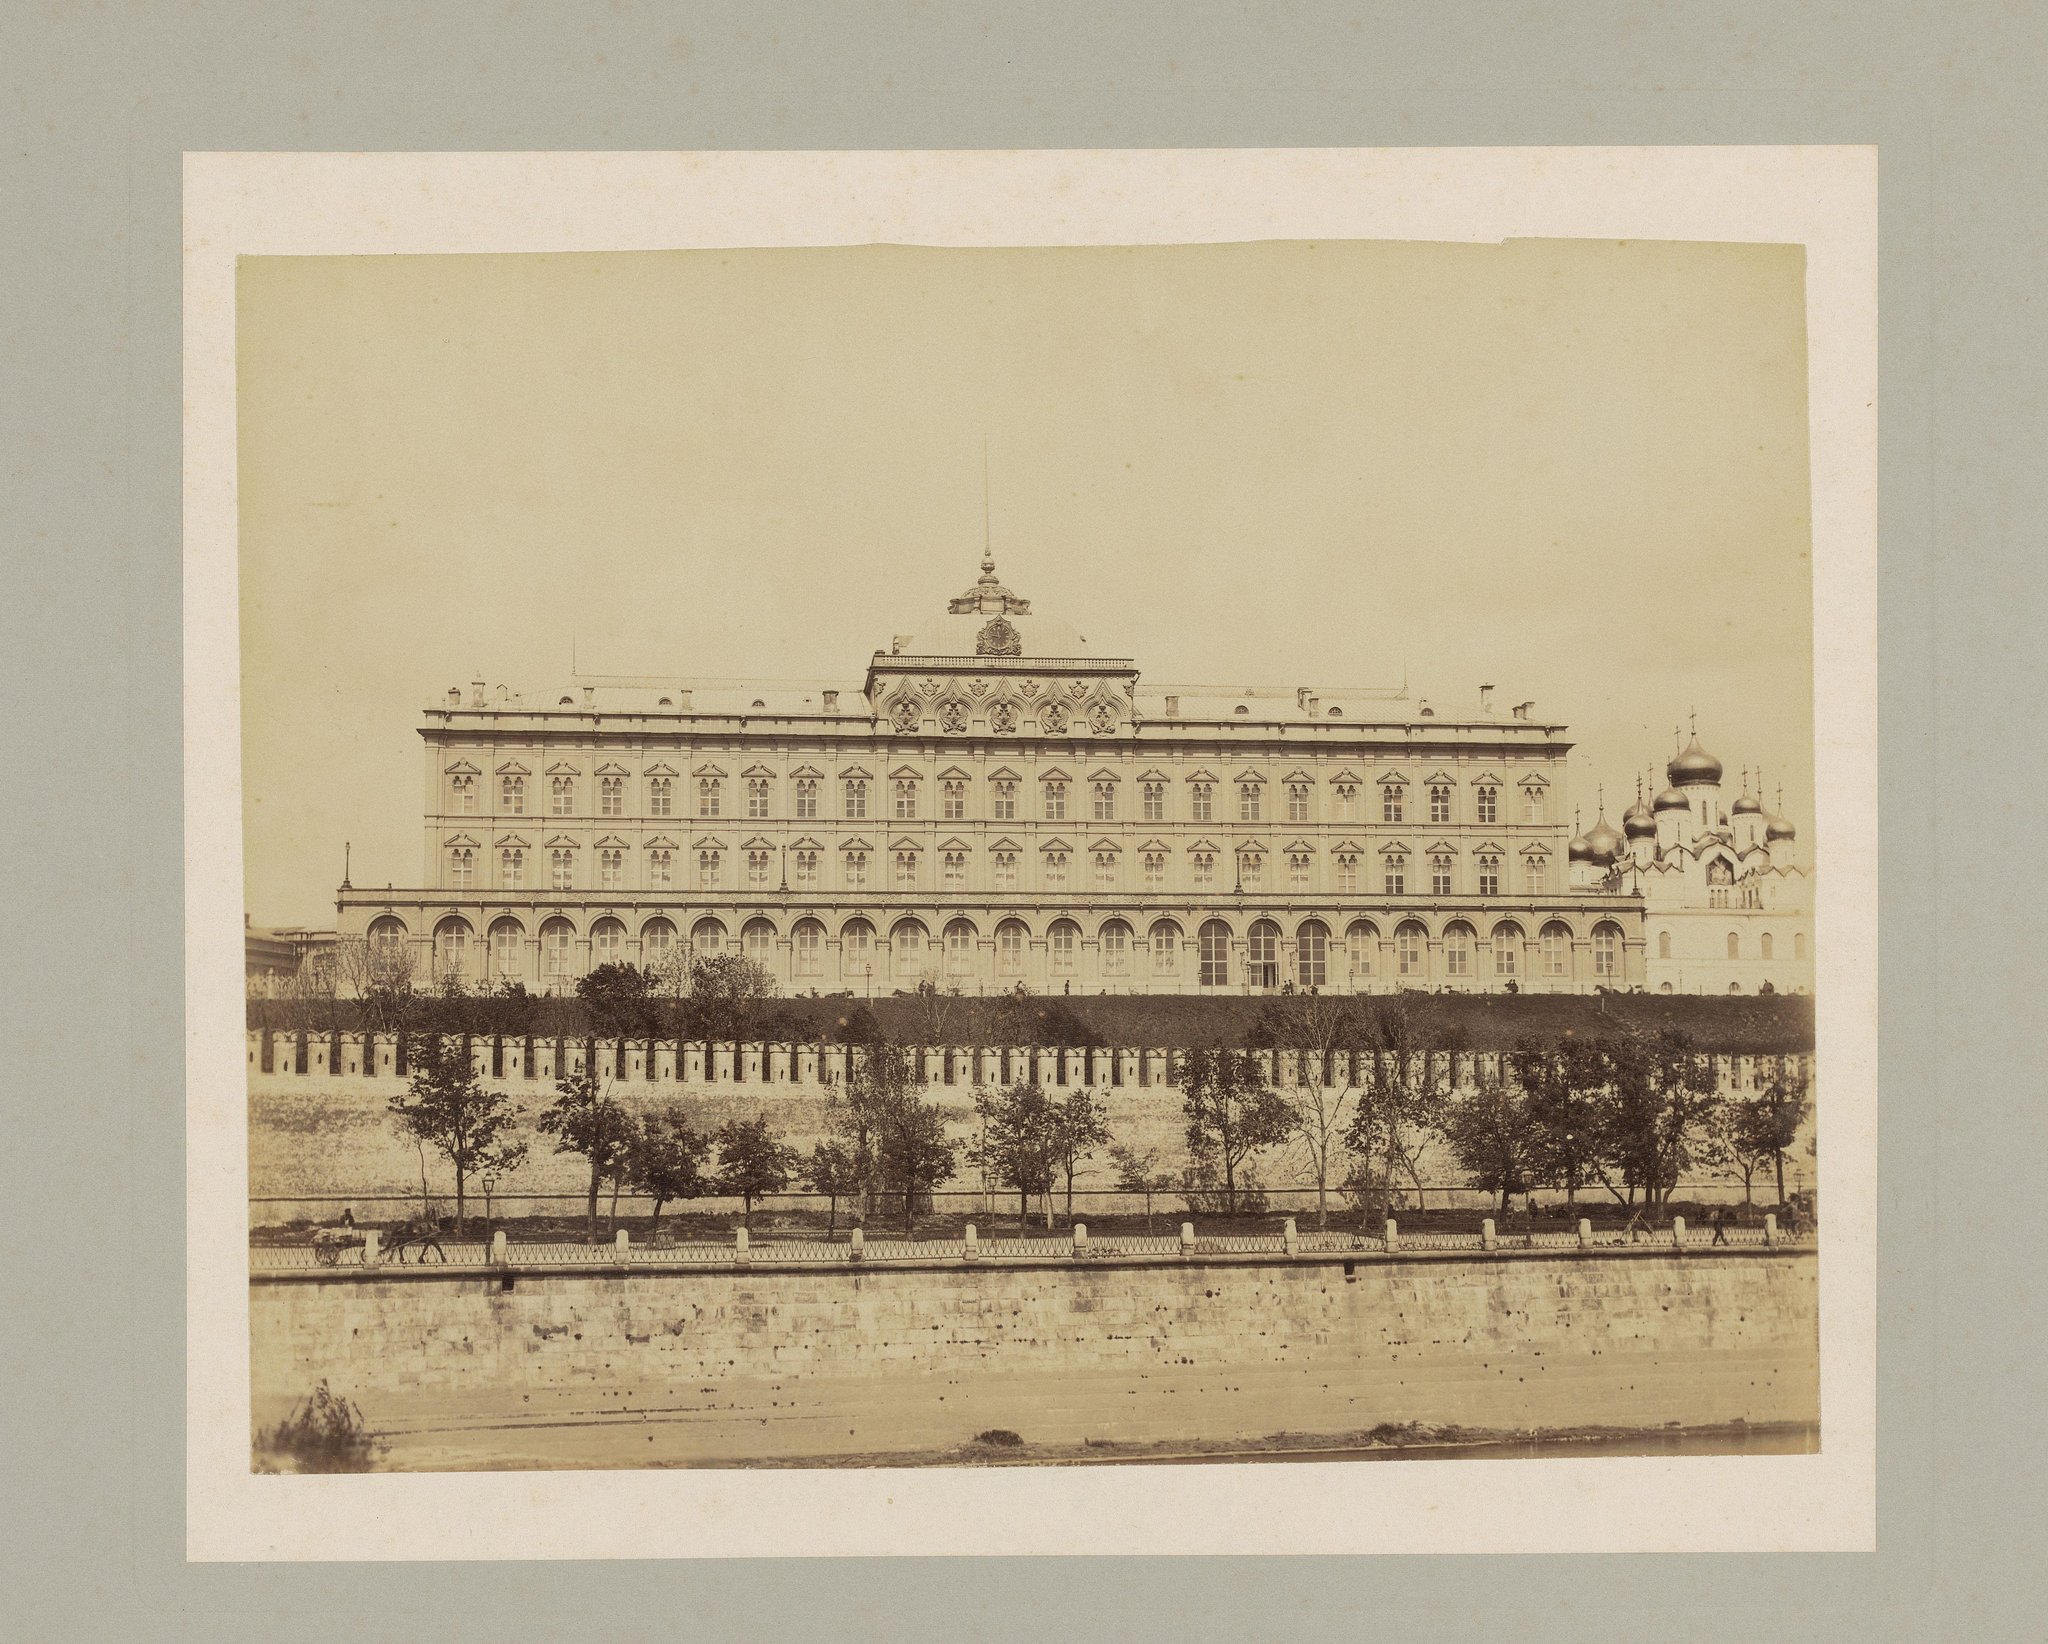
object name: photograph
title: Groot Paleis in het Kremlin van Moskou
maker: Anonymous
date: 1860-1890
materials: cardboard, paper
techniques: albumen print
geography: moscow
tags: palace